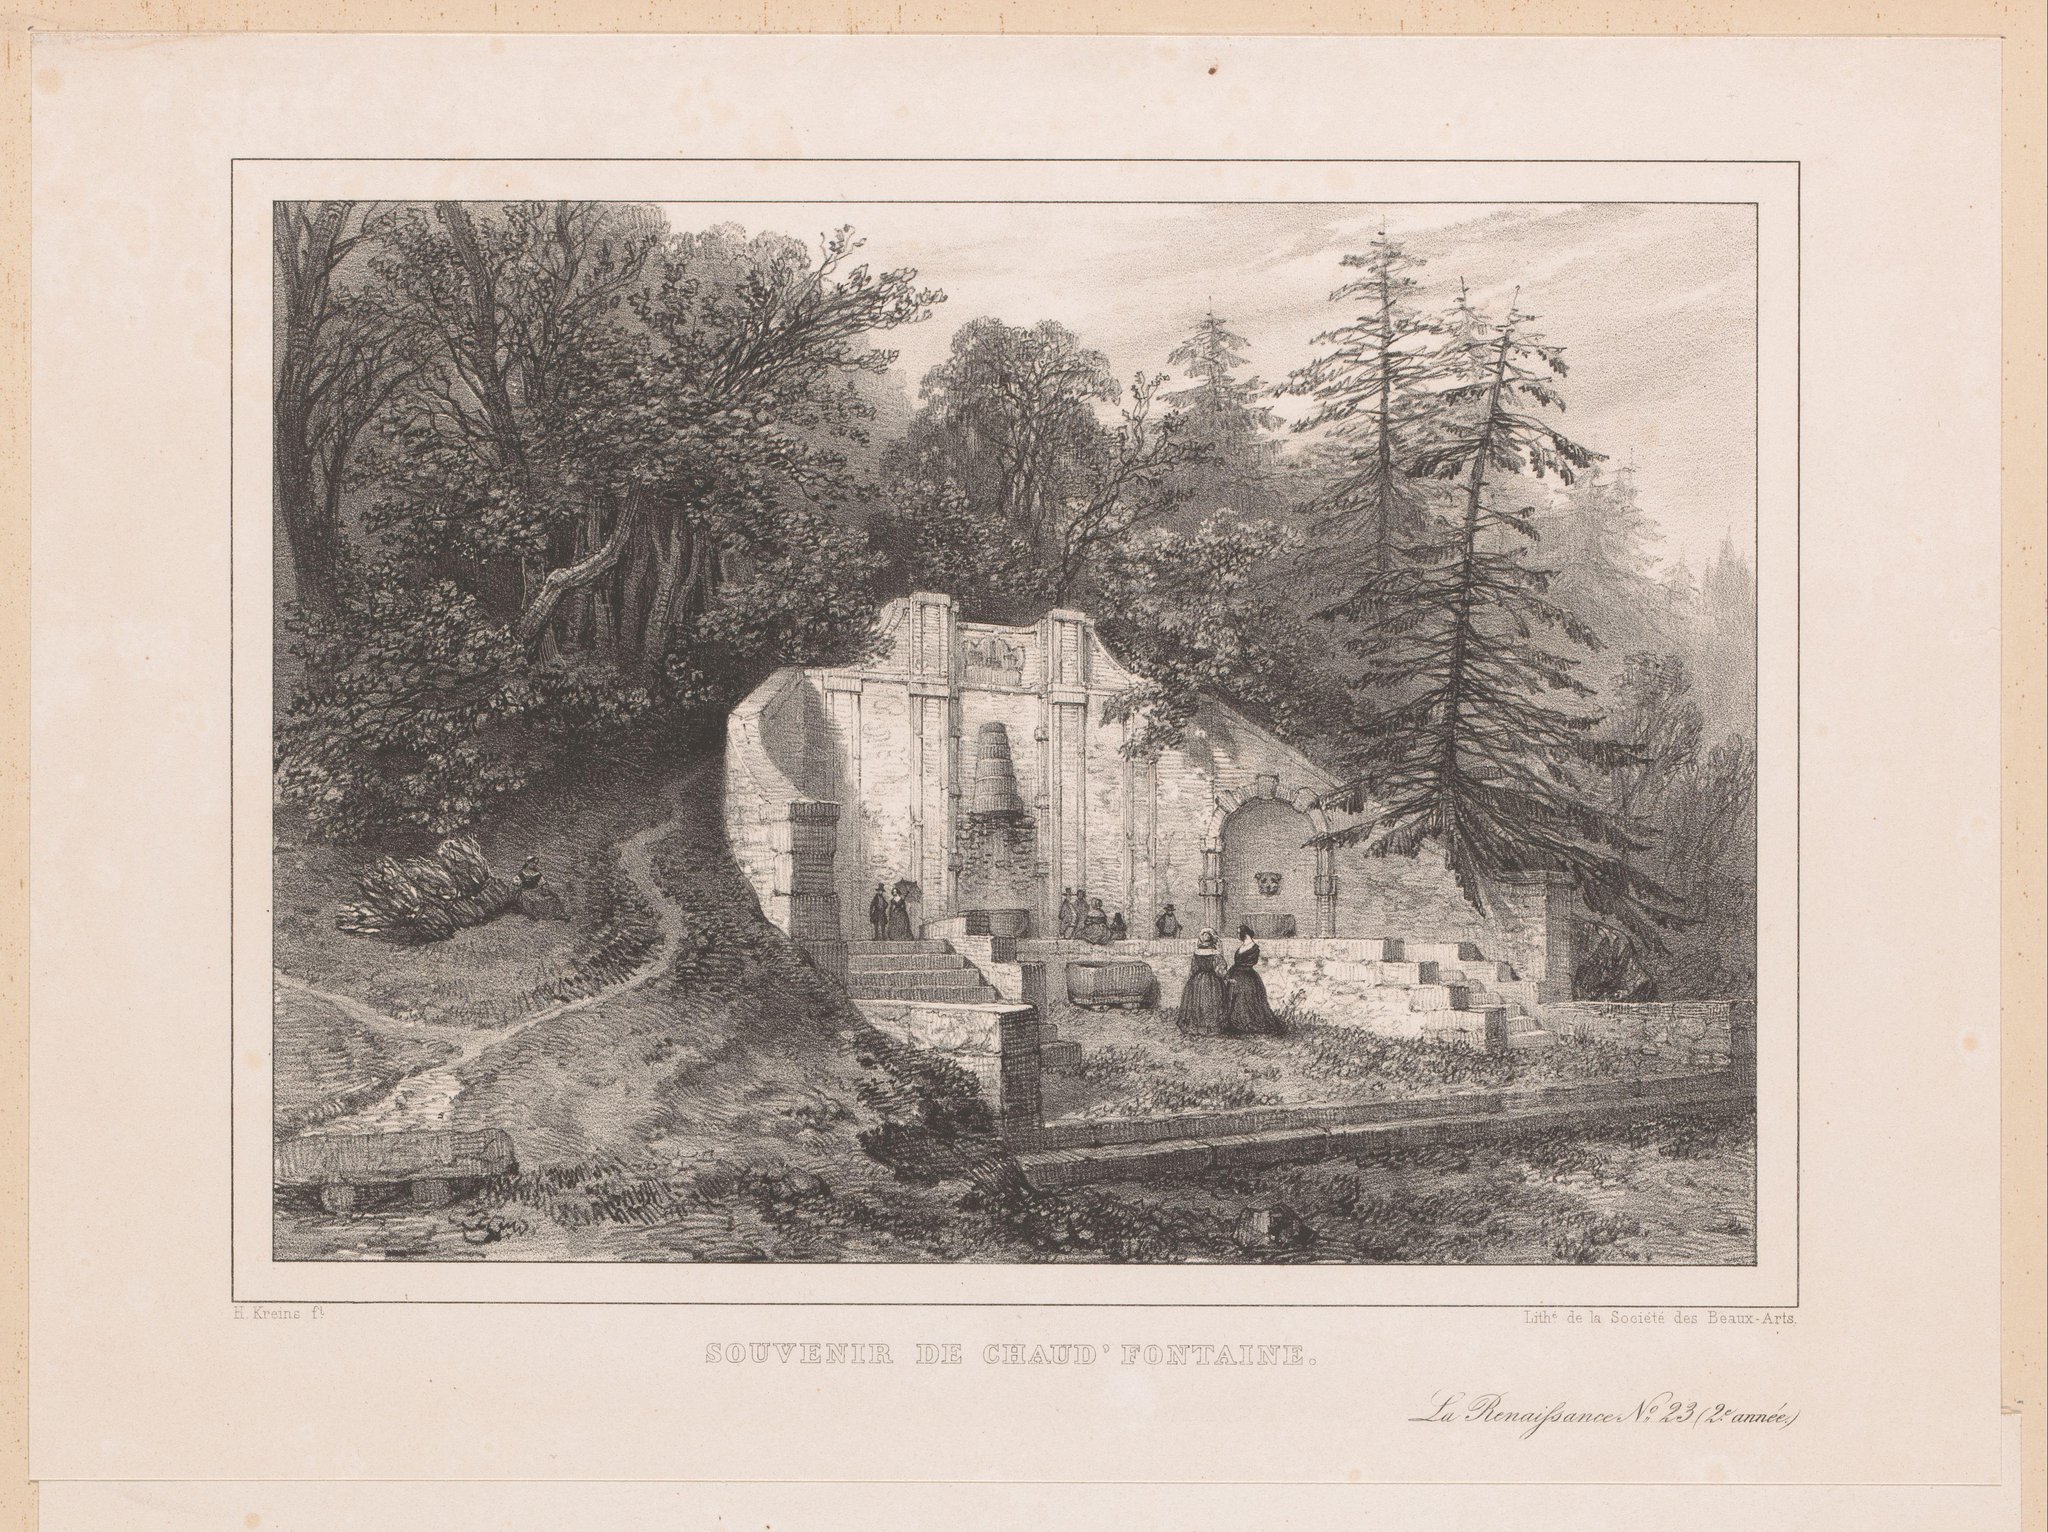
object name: print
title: Gezicht op de bron van Chaudfontaine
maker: hilaire antoine kreins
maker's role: print maker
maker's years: 1806-1862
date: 1840-1841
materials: paper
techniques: lithograph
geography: brussels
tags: mineral water, spring, source of river or stream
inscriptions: collector's mark: Lugt 2760, collector's mark: Lugt 2228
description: Prent uit: La Renaissance. Chronique des arts et de la littérature 2 (1840-1841), pl. 23.